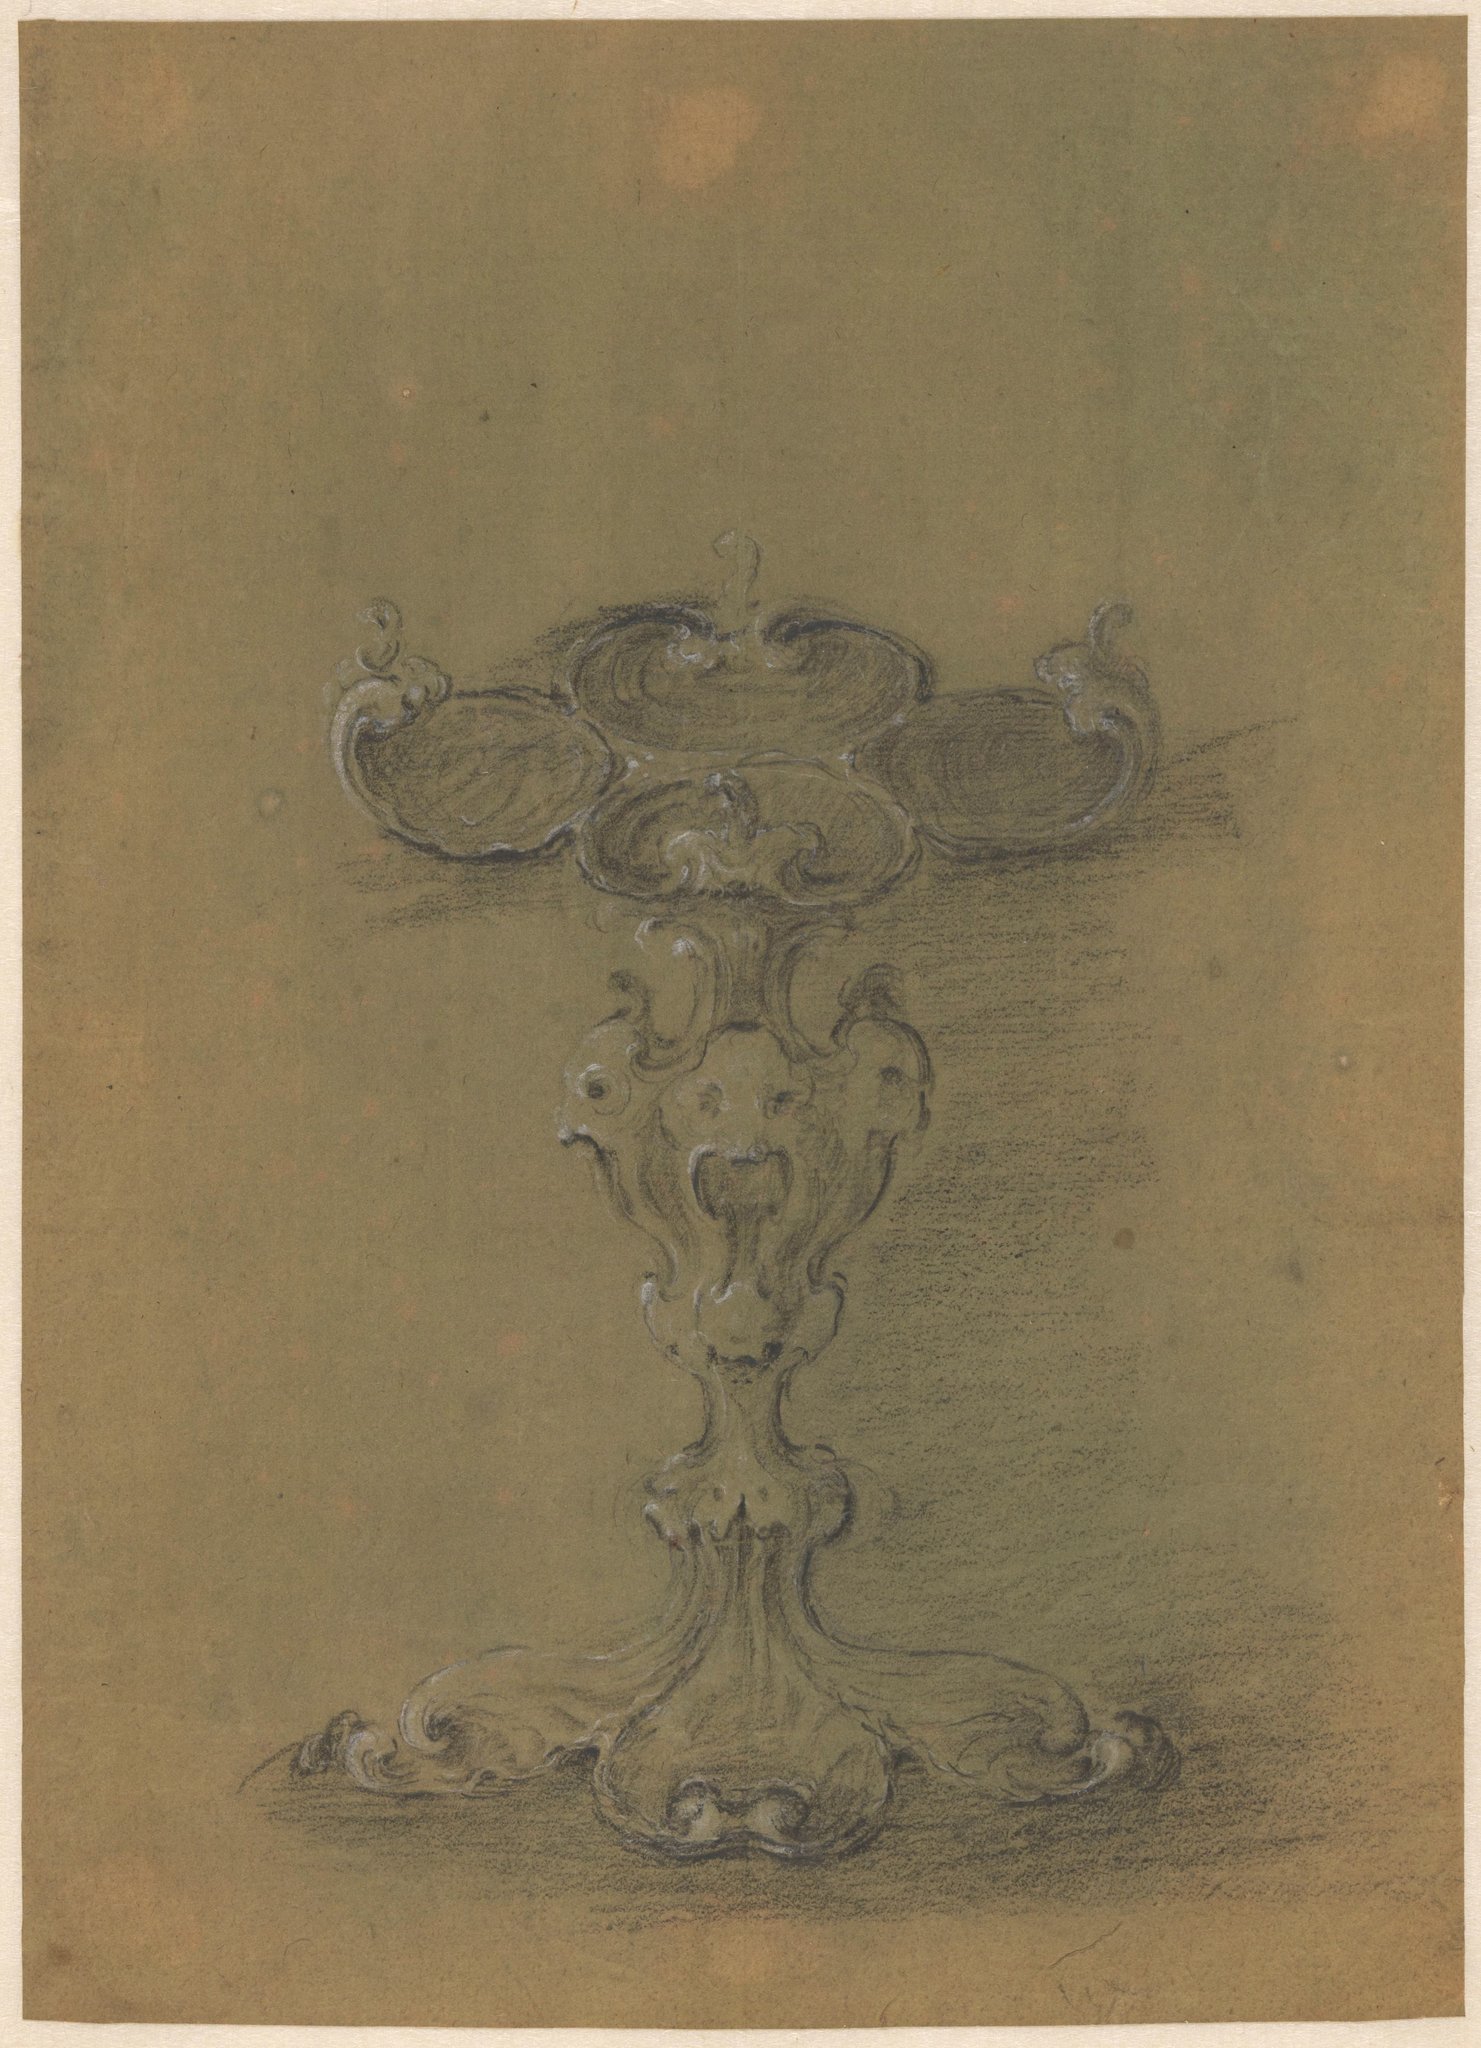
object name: drawing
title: Design for a Condiment Dish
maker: johannes lutma (1584-1669)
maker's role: draughtsman, print maker, silversmith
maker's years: 1584-1669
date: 1640-1650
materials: paper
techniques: drawing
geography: amsterdam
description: All of the parts of this dish have been deformed into auricular shapes. In this drawing Lutma manages to convey the ambiguous, fluent nature of kwab ornament. The dish itself is tilted to show that it accommodates four containers for spices. The drawing thus provides a maximum of information for prospective clients as well as the silversmith.